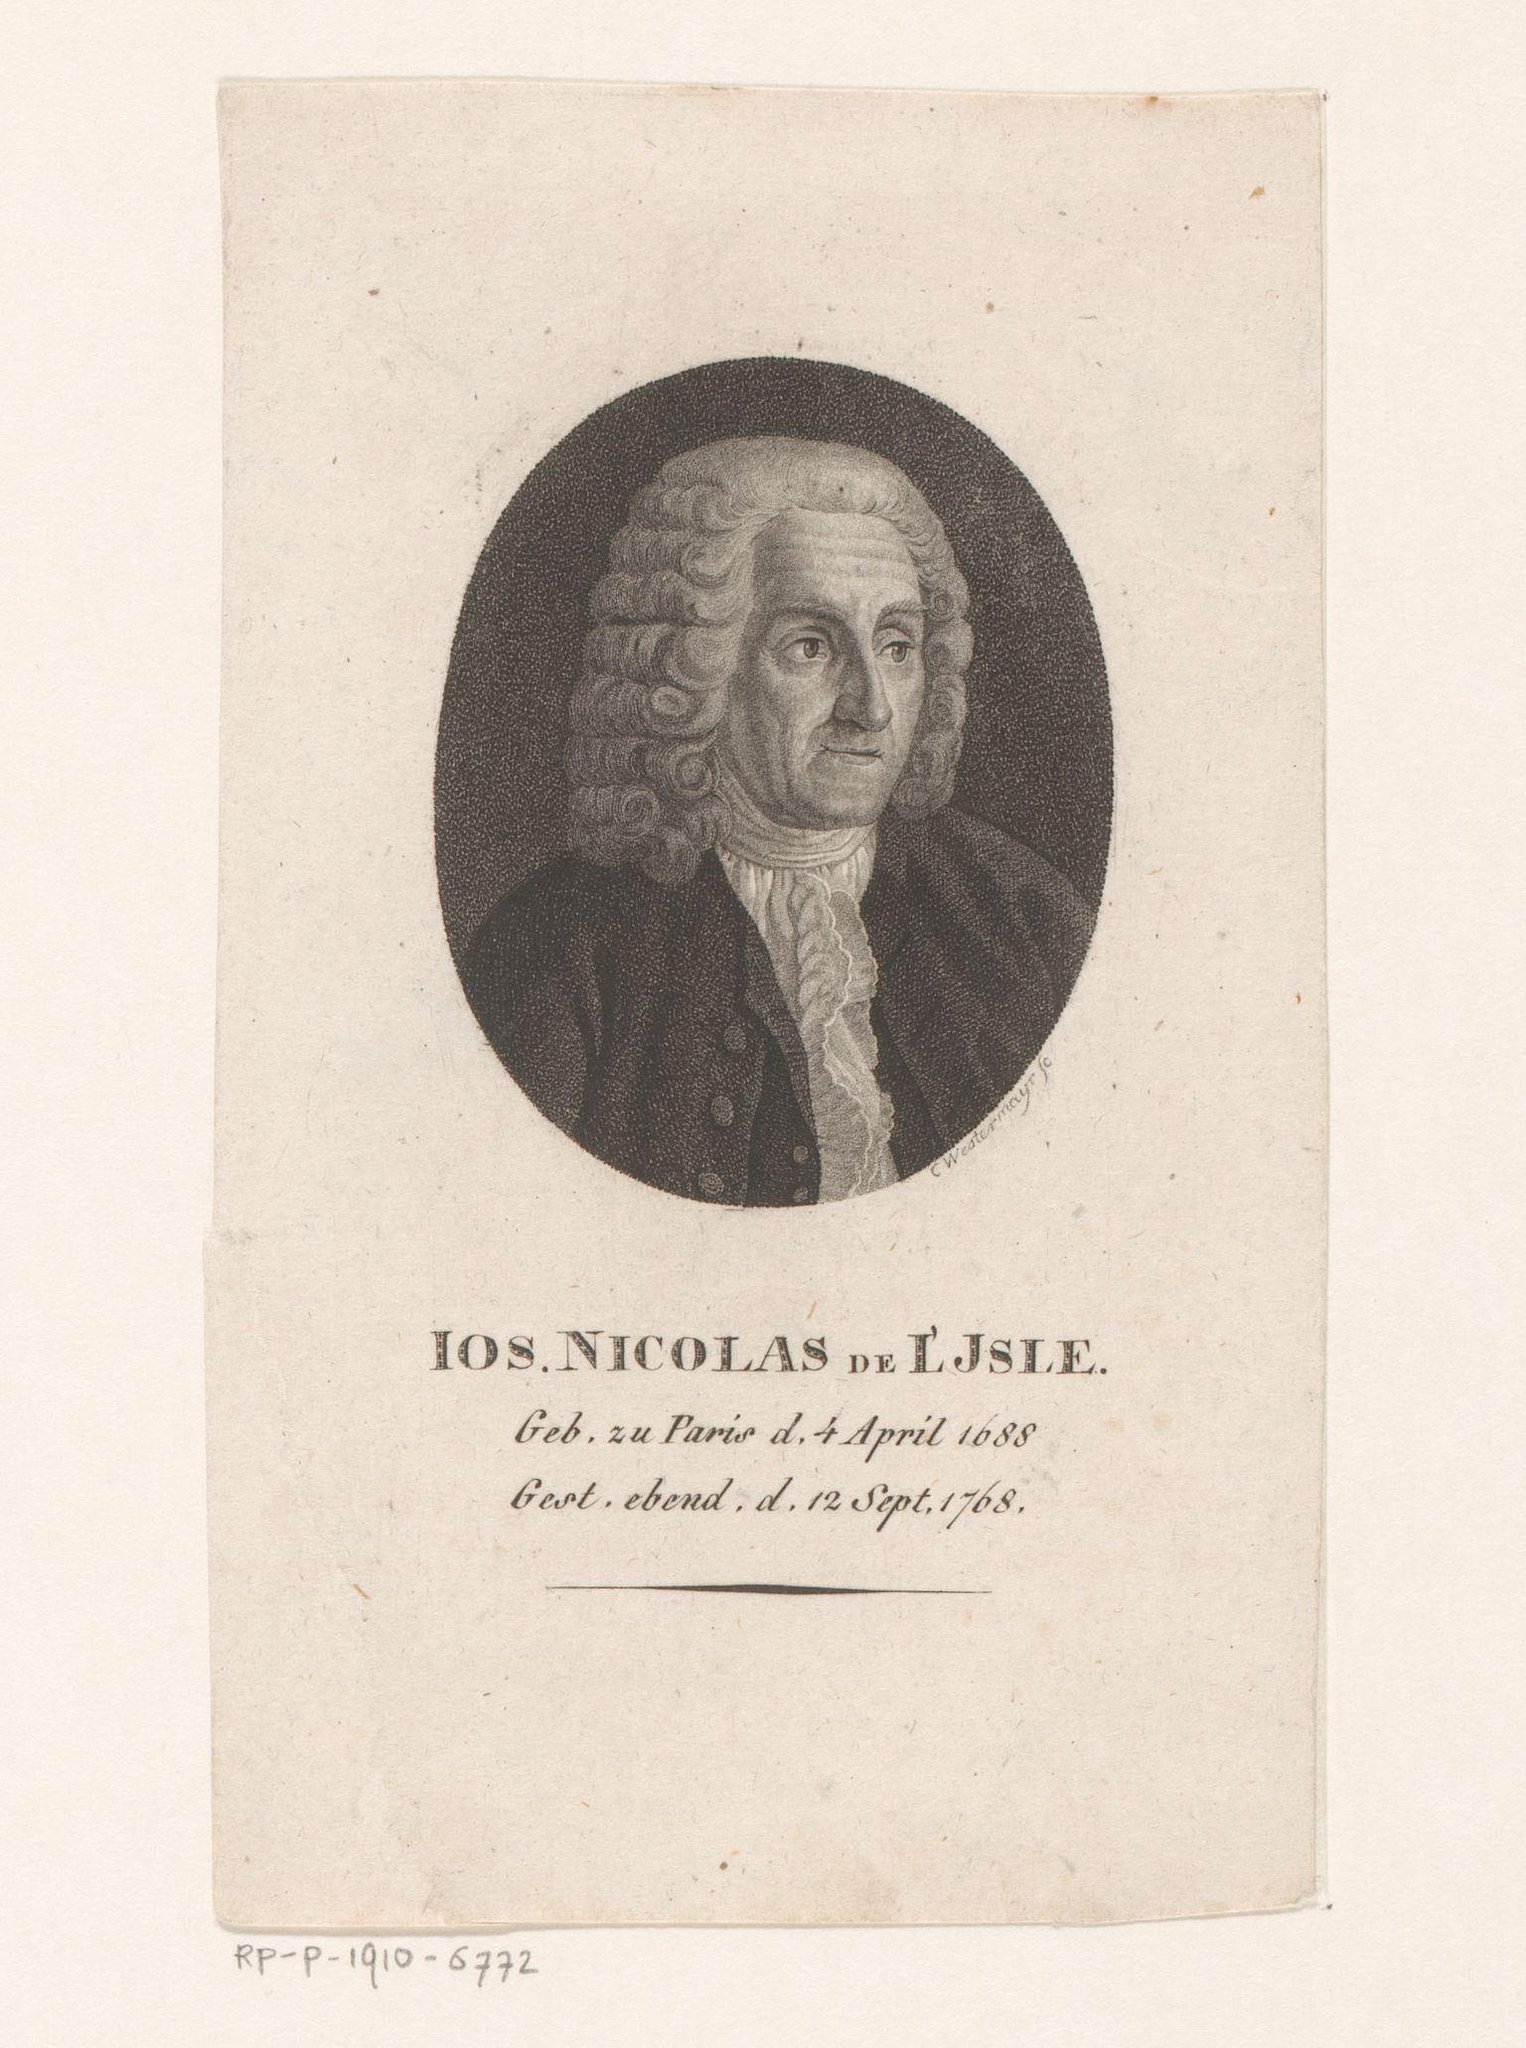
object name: print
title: Portret van Joseph-Nicolas Delisle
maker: konrad westermayr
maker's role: print maker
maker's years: 1765-1834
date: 1775-1834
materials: paper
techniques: engraving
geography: germany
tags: paris, historical persons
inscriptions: collector's mark: Lugt 2228